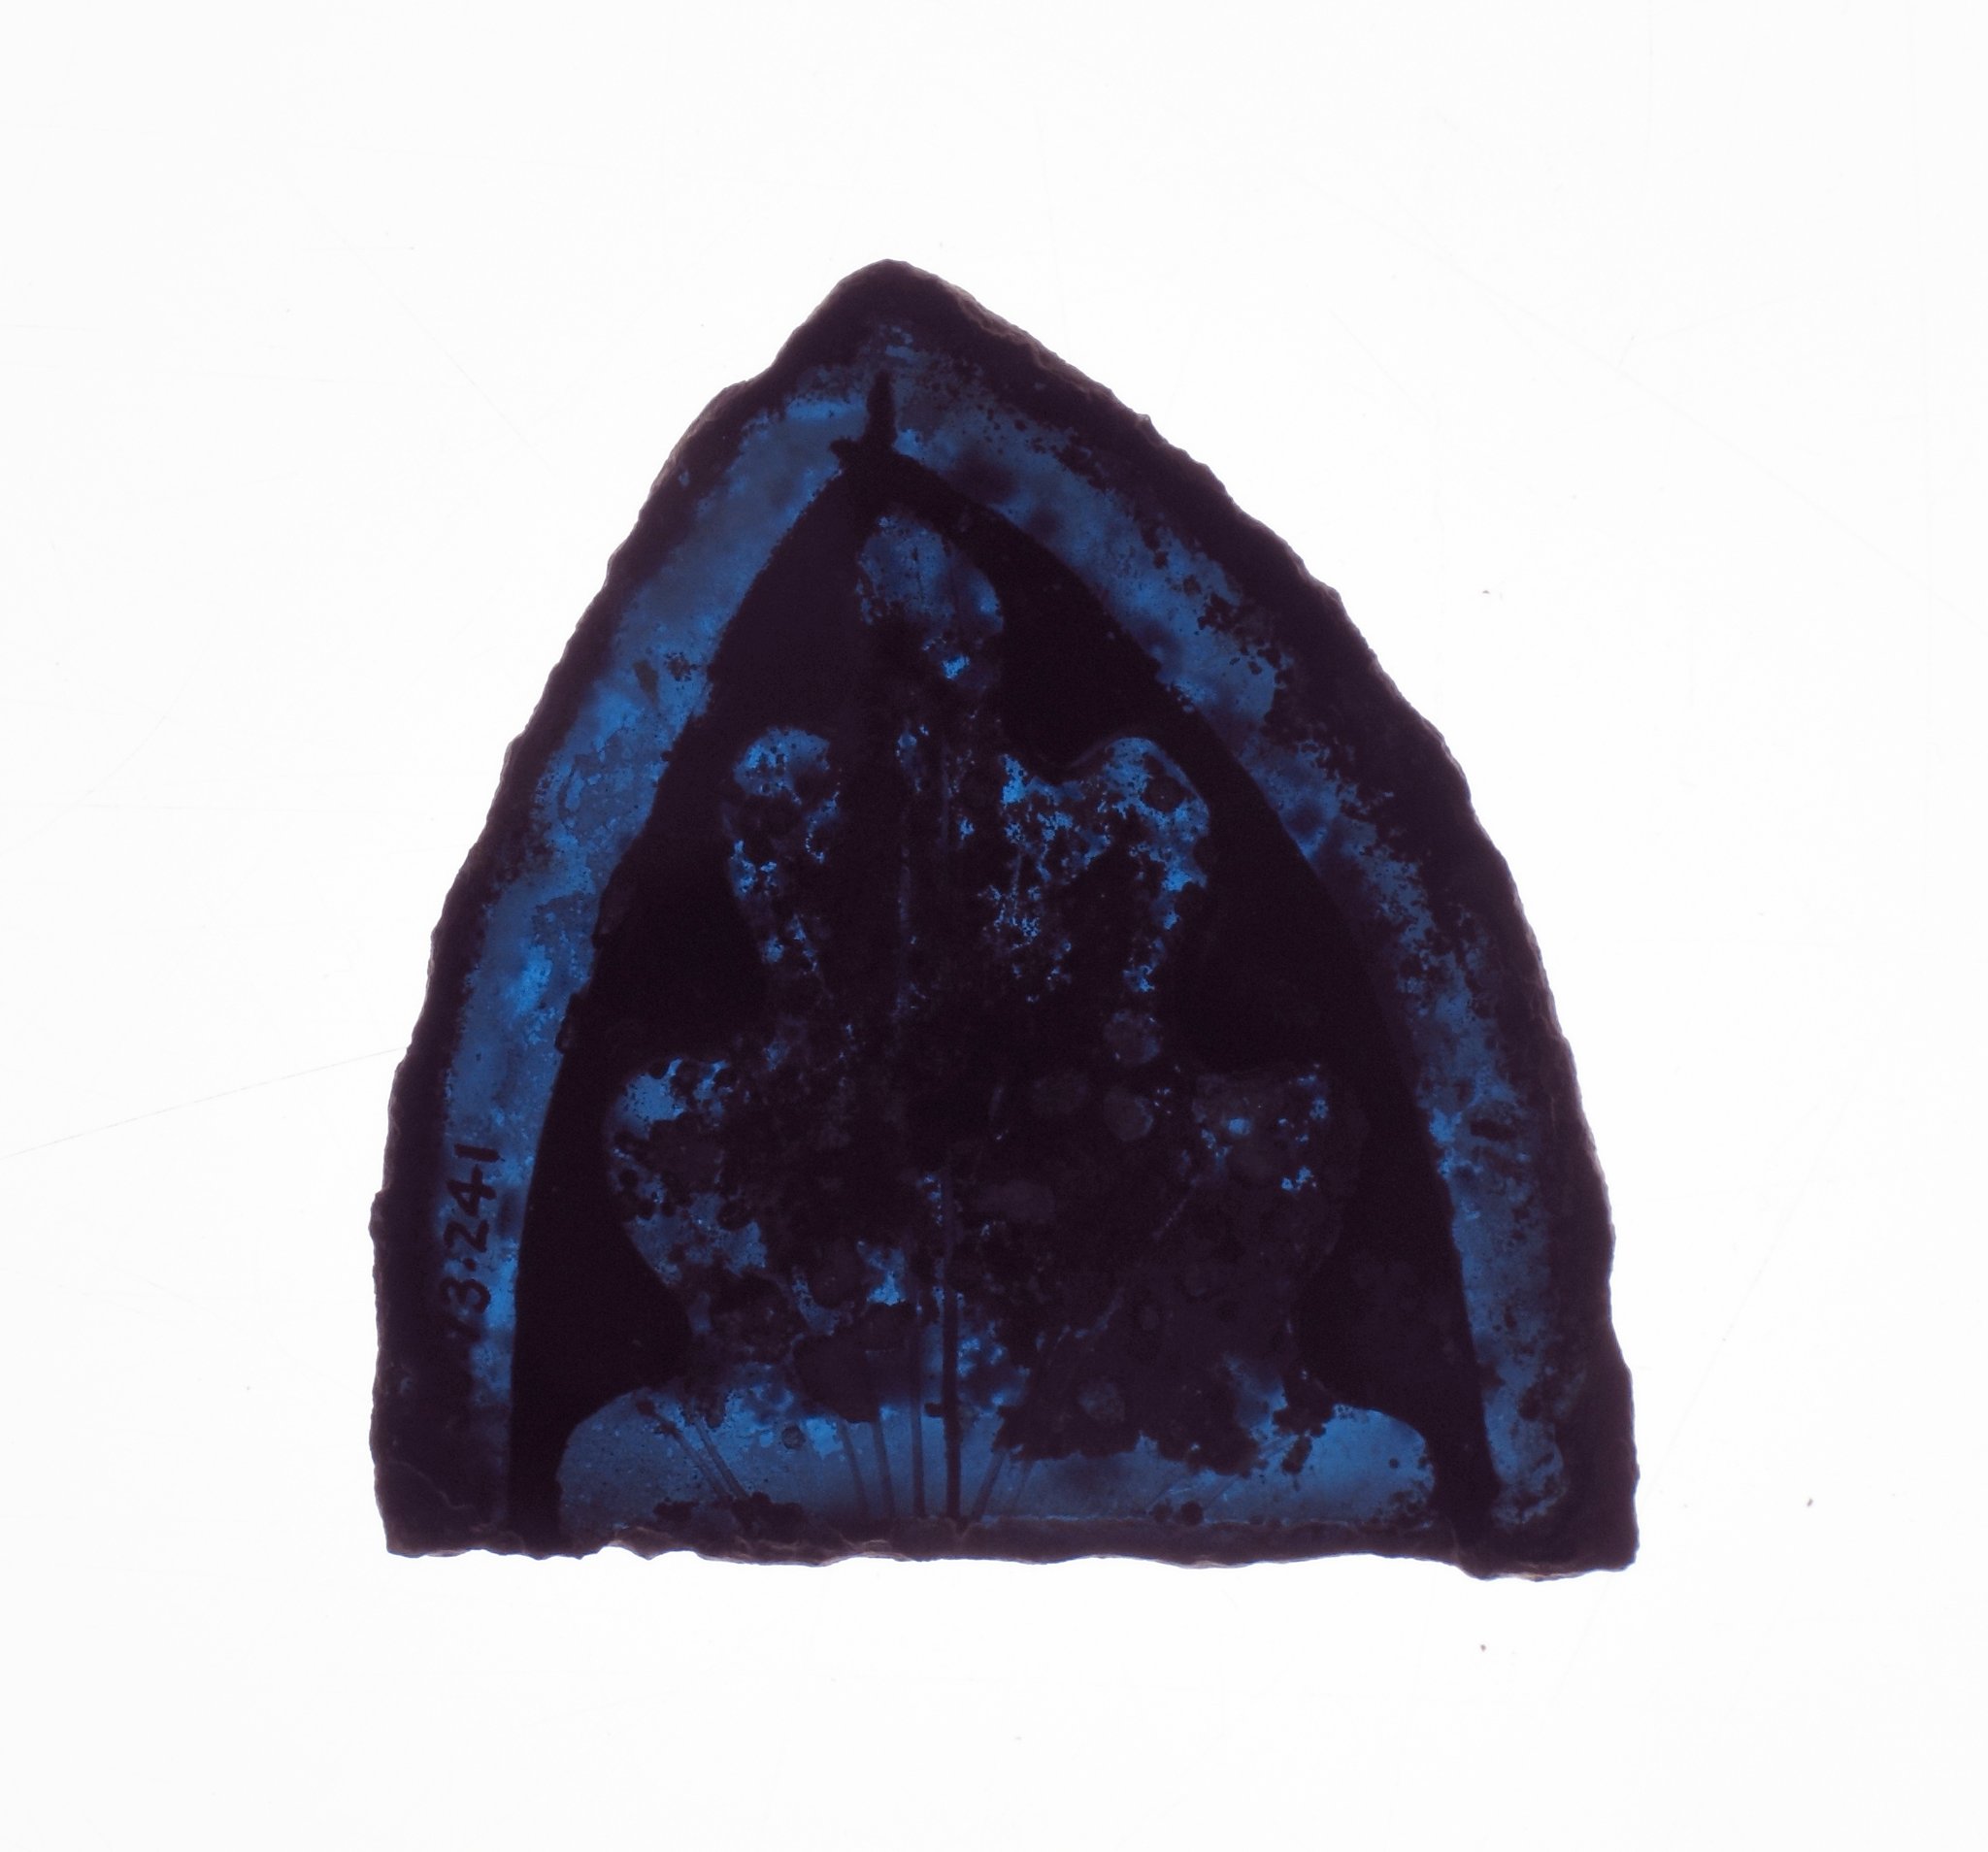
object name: fragment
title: Glass Fragment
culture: european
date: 1201-1400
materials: glass, metal